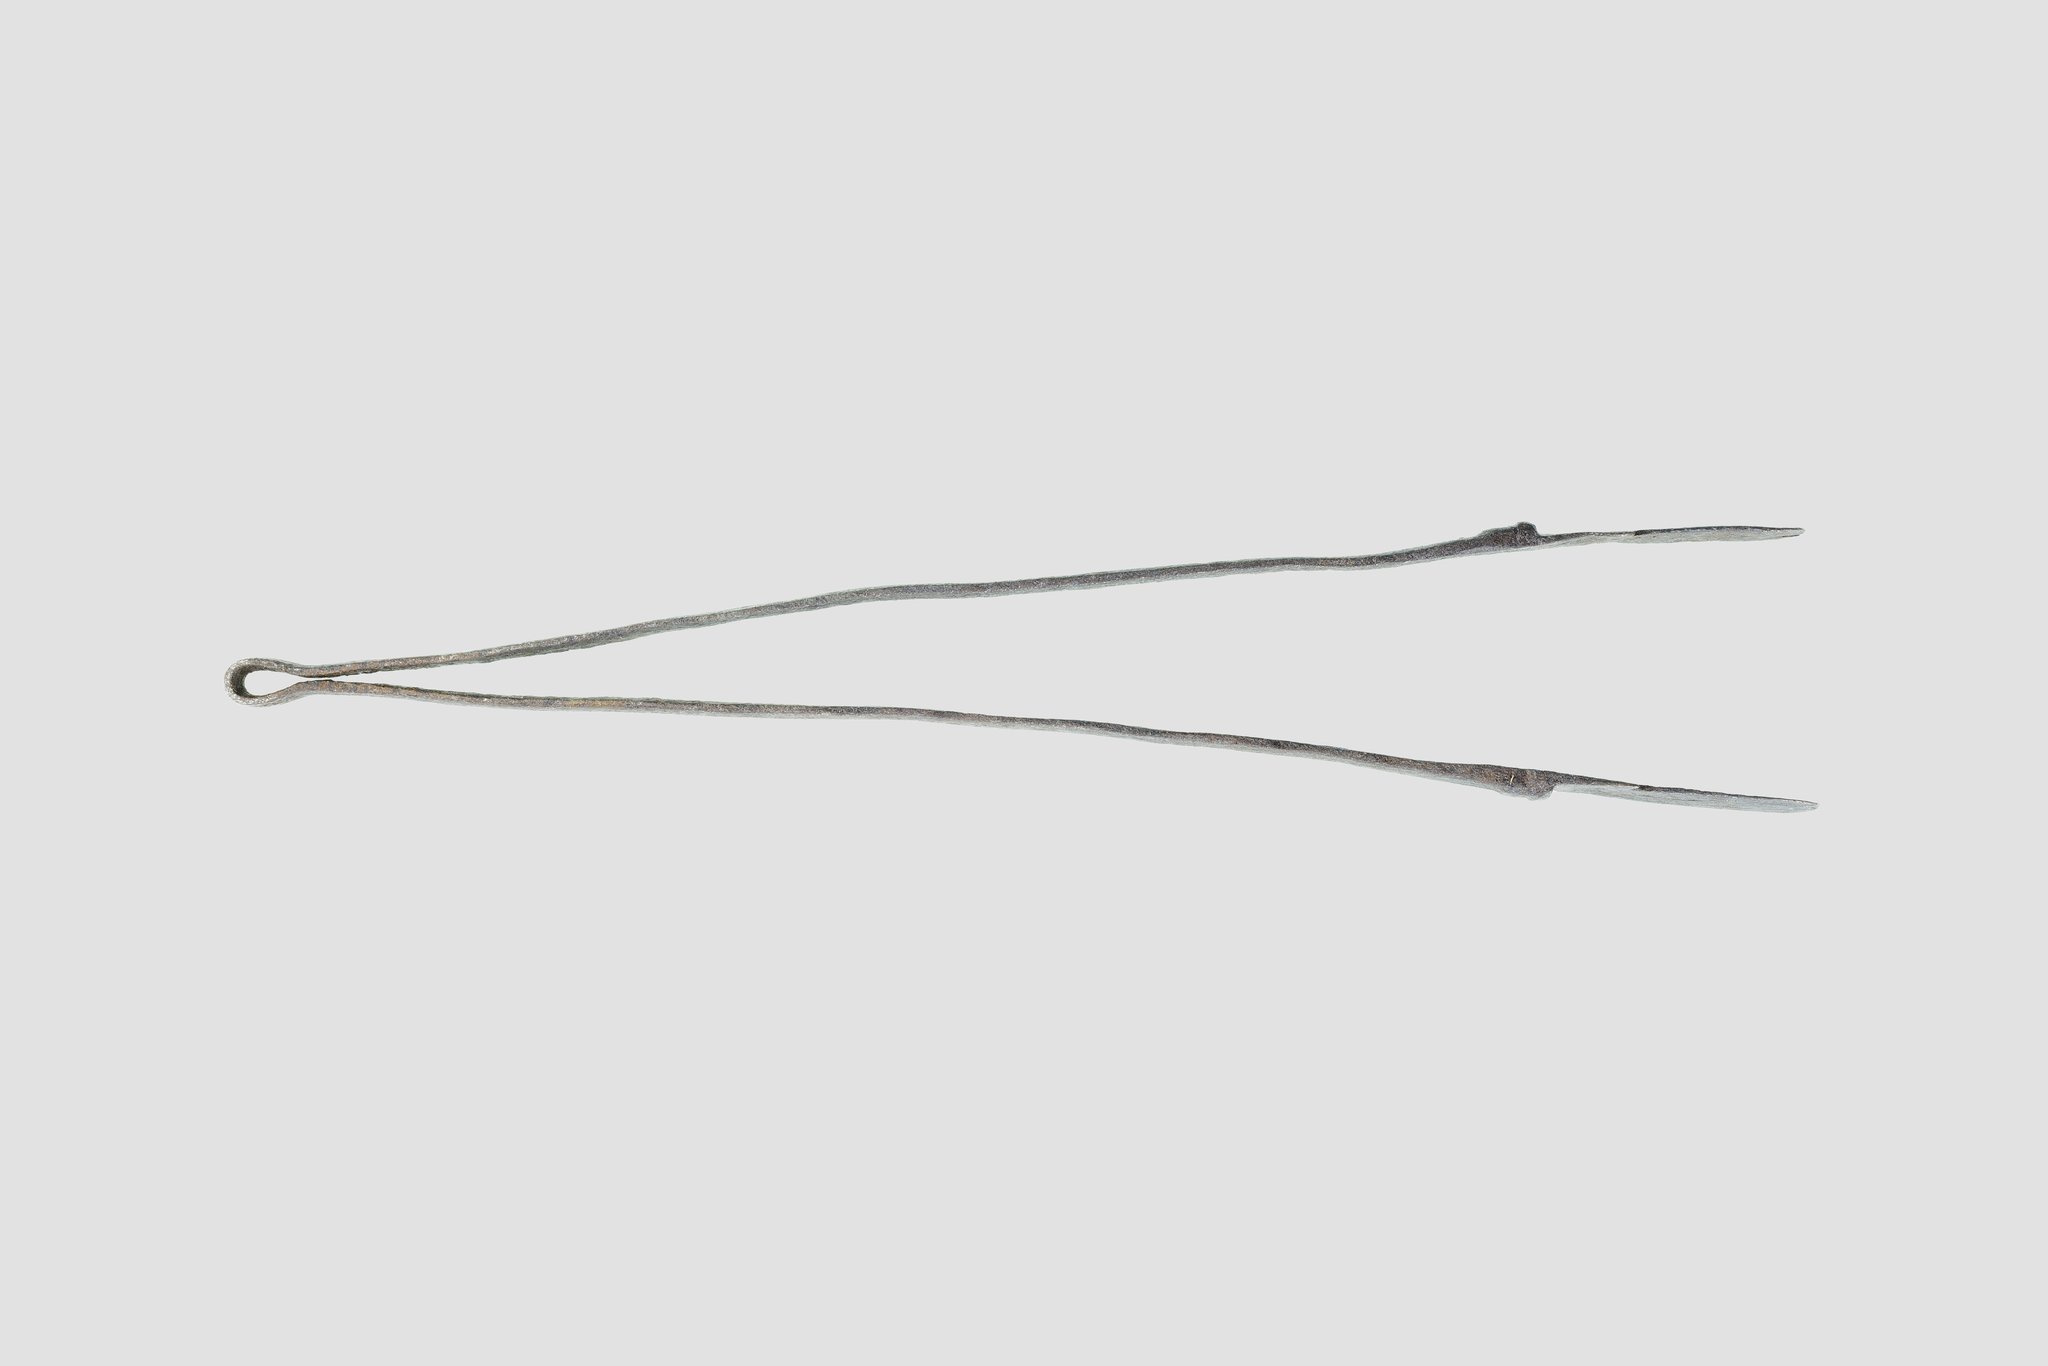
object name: tweezer ending in hand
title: Tweezers ending in hands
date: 664-332 BCE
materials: iron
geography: egypt